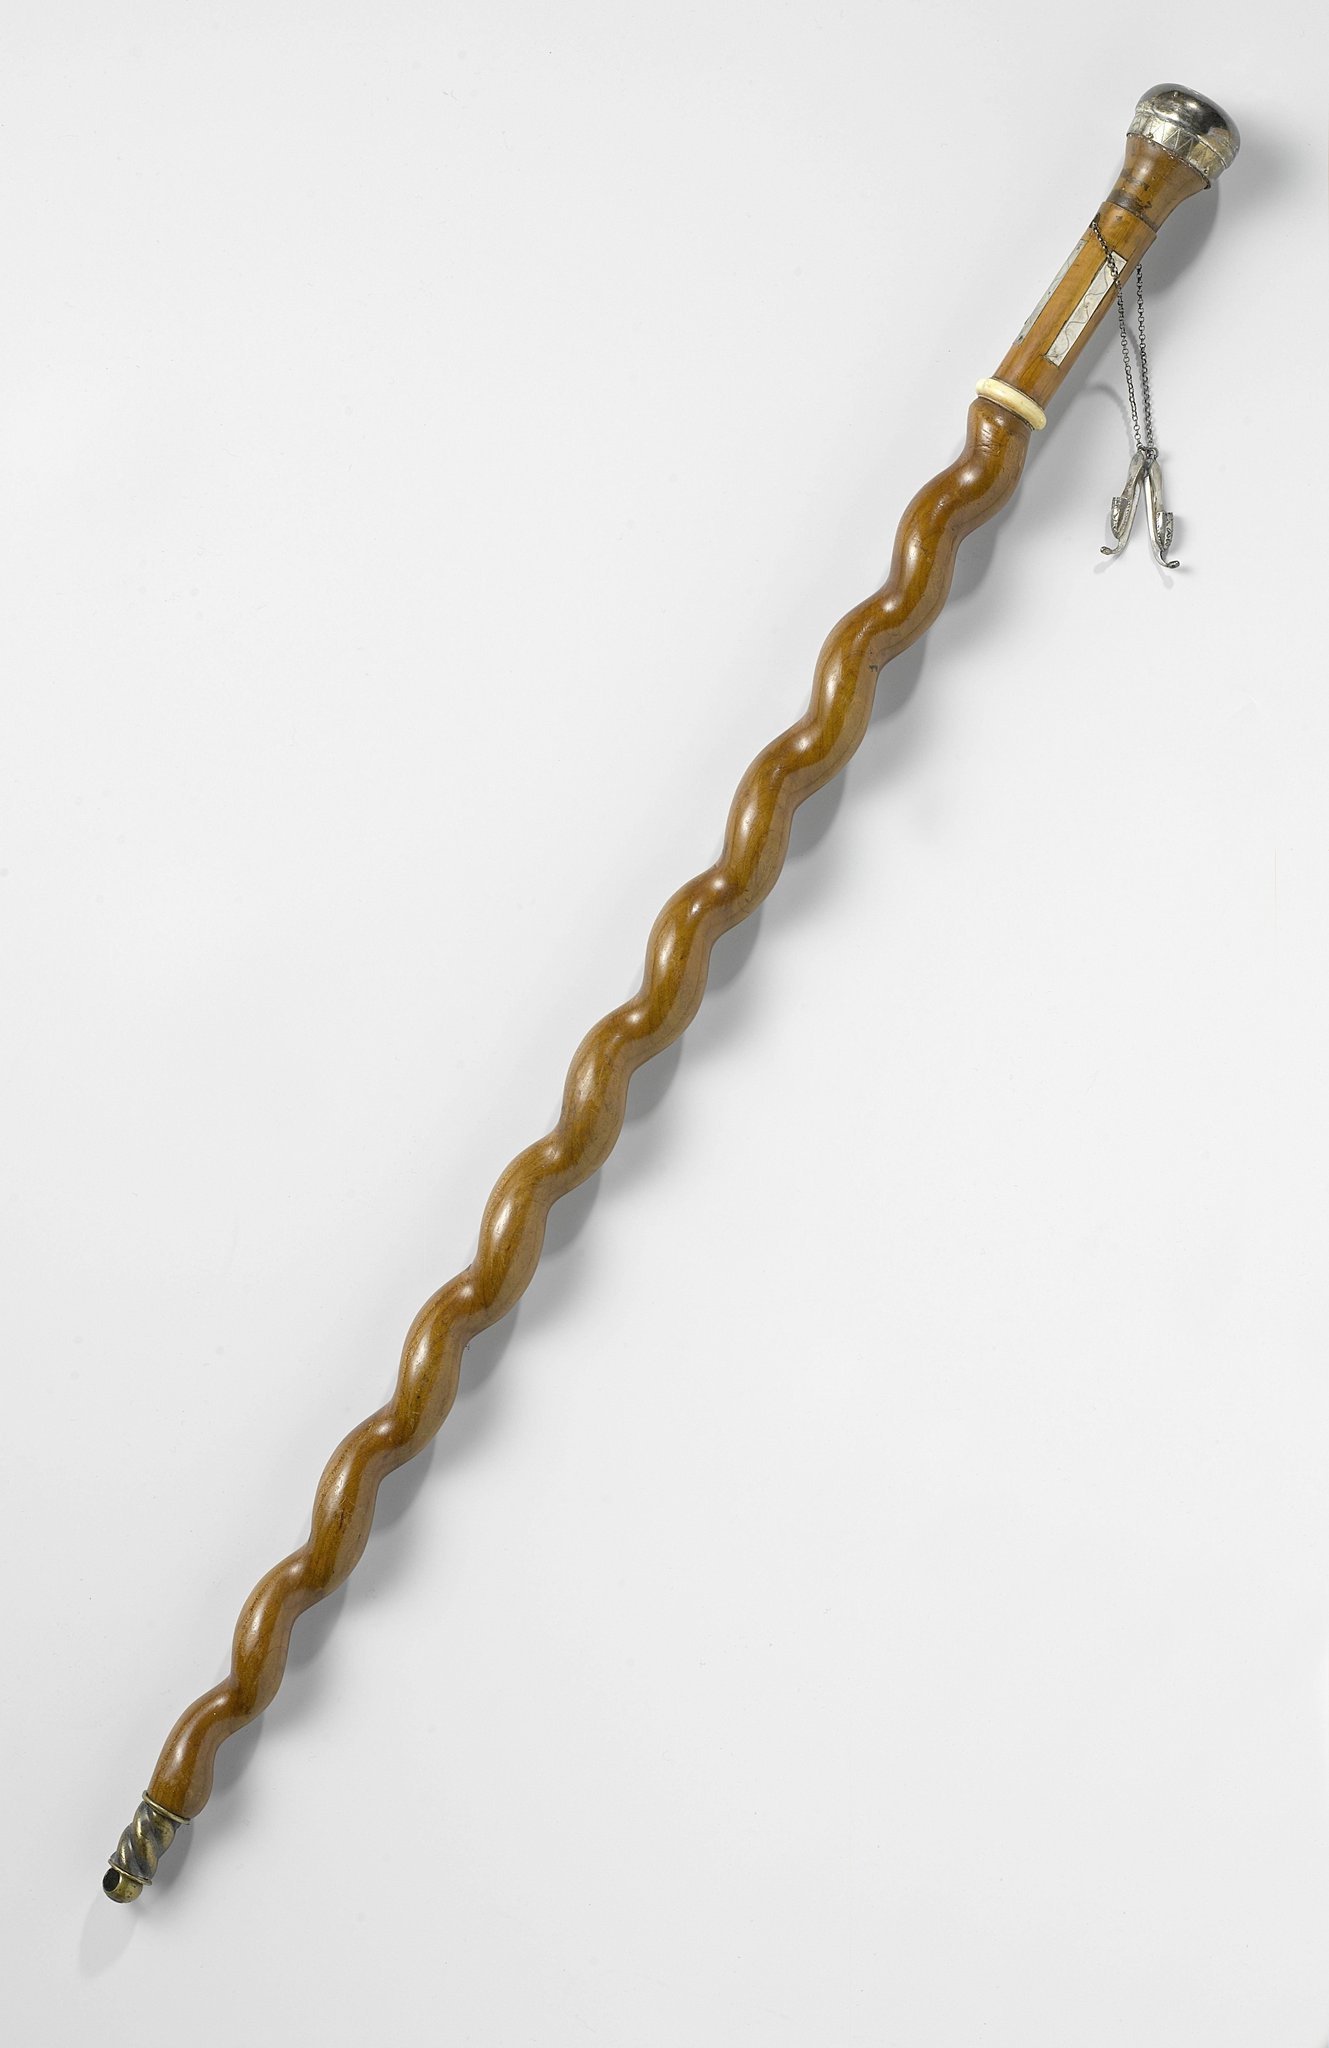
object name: walking stick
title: Ice stick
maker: Anonymous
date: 1795-1800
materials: wood, brass, copper, ivory, silver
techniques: cutting, forging, striking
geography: netherlands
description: Nowadays, an ‘ice stick’ is associated with a winter sport, similar to curling, in which a smooth disc with a stem is slid as far as possible across an icy surface. Formerly, sticks with a metal tip were used as an aid for walking on ice. The two little silver skates on a chain most likely refer to this function.